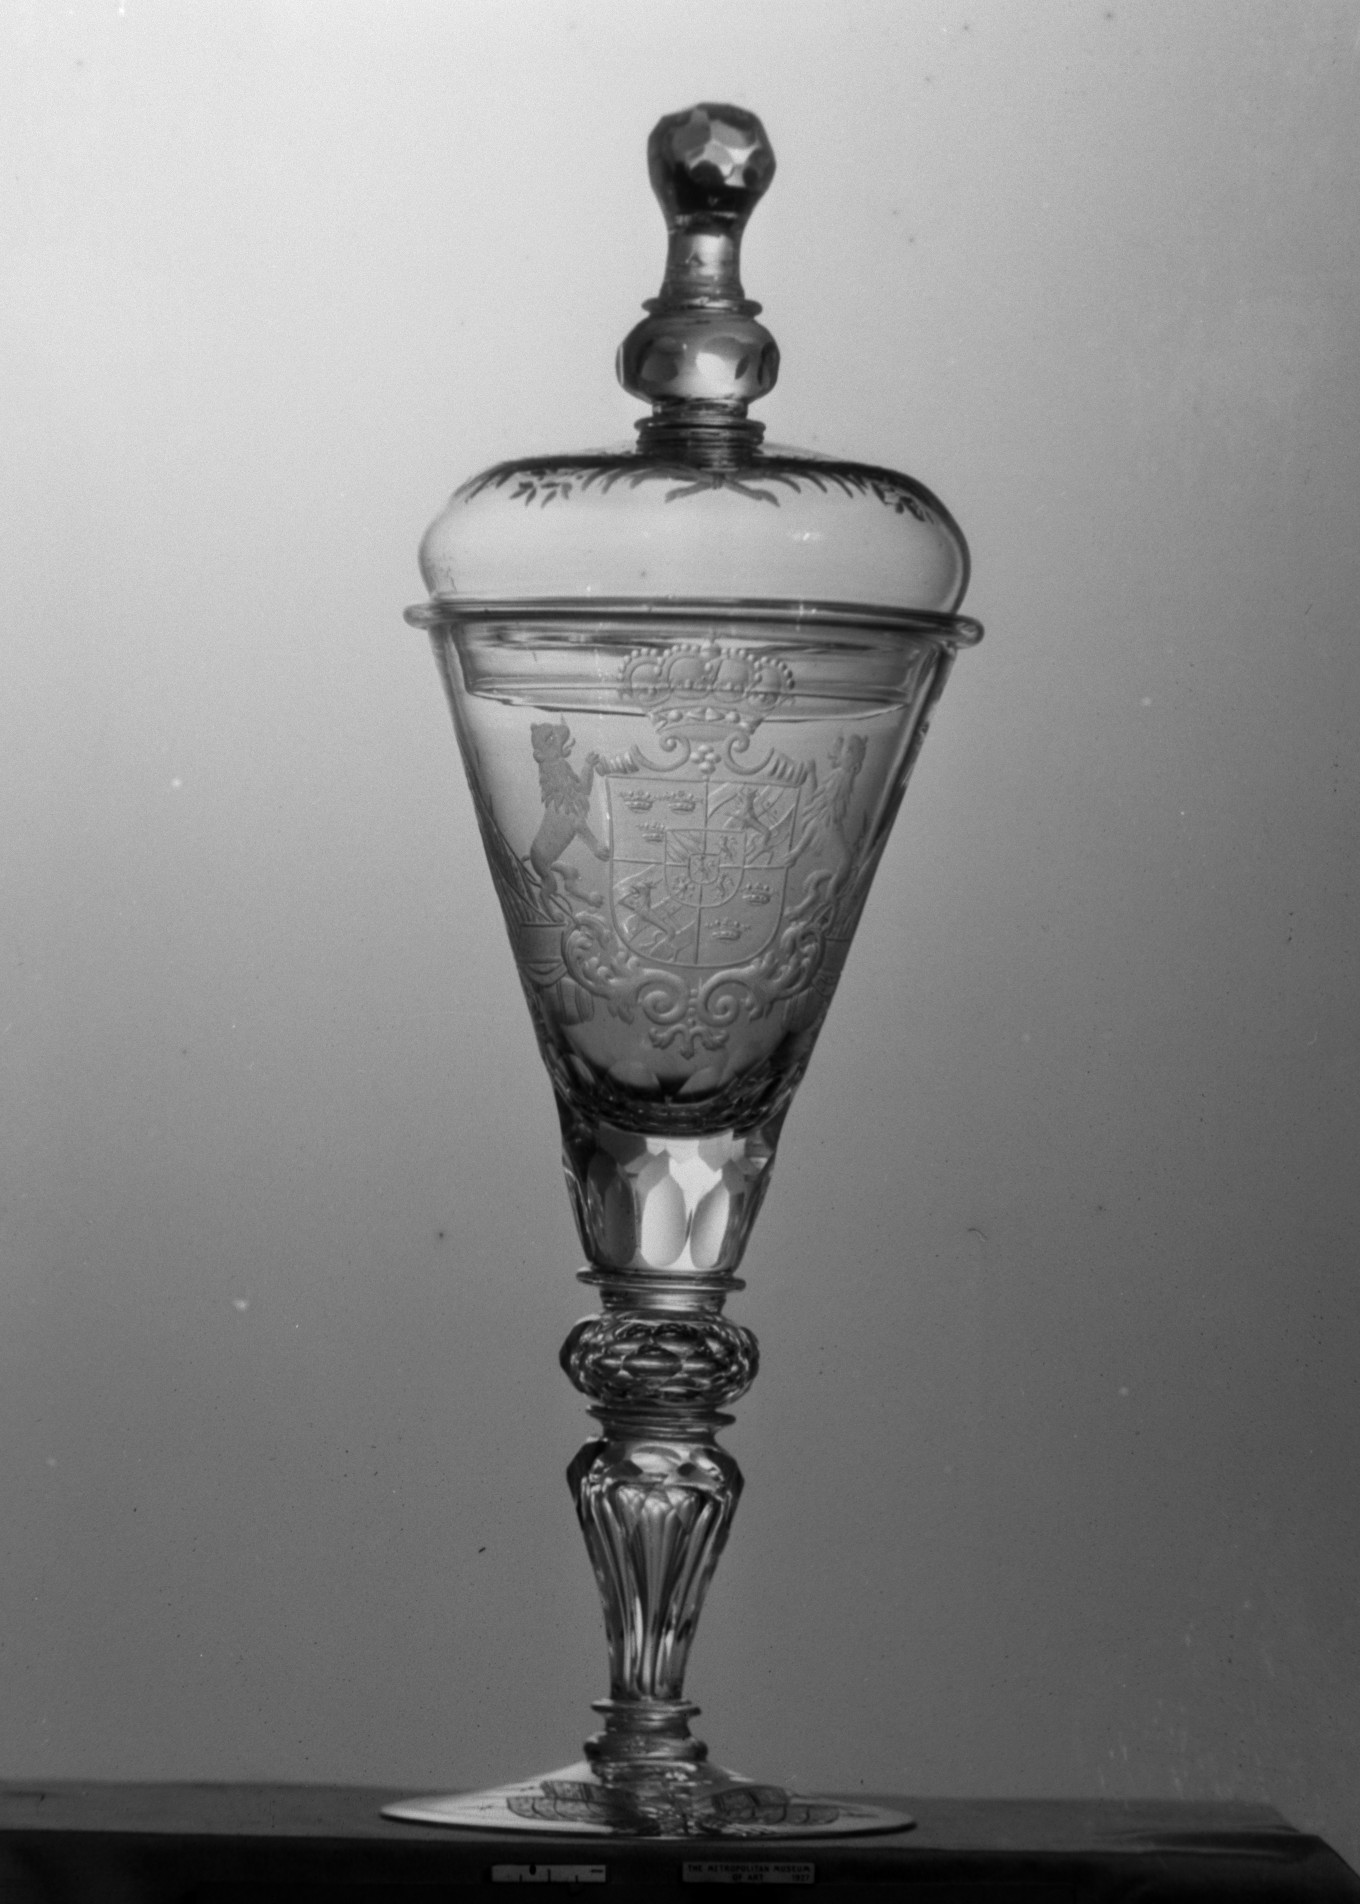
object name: standing cup with cover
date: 1701-1733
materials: glass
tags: coat of arms